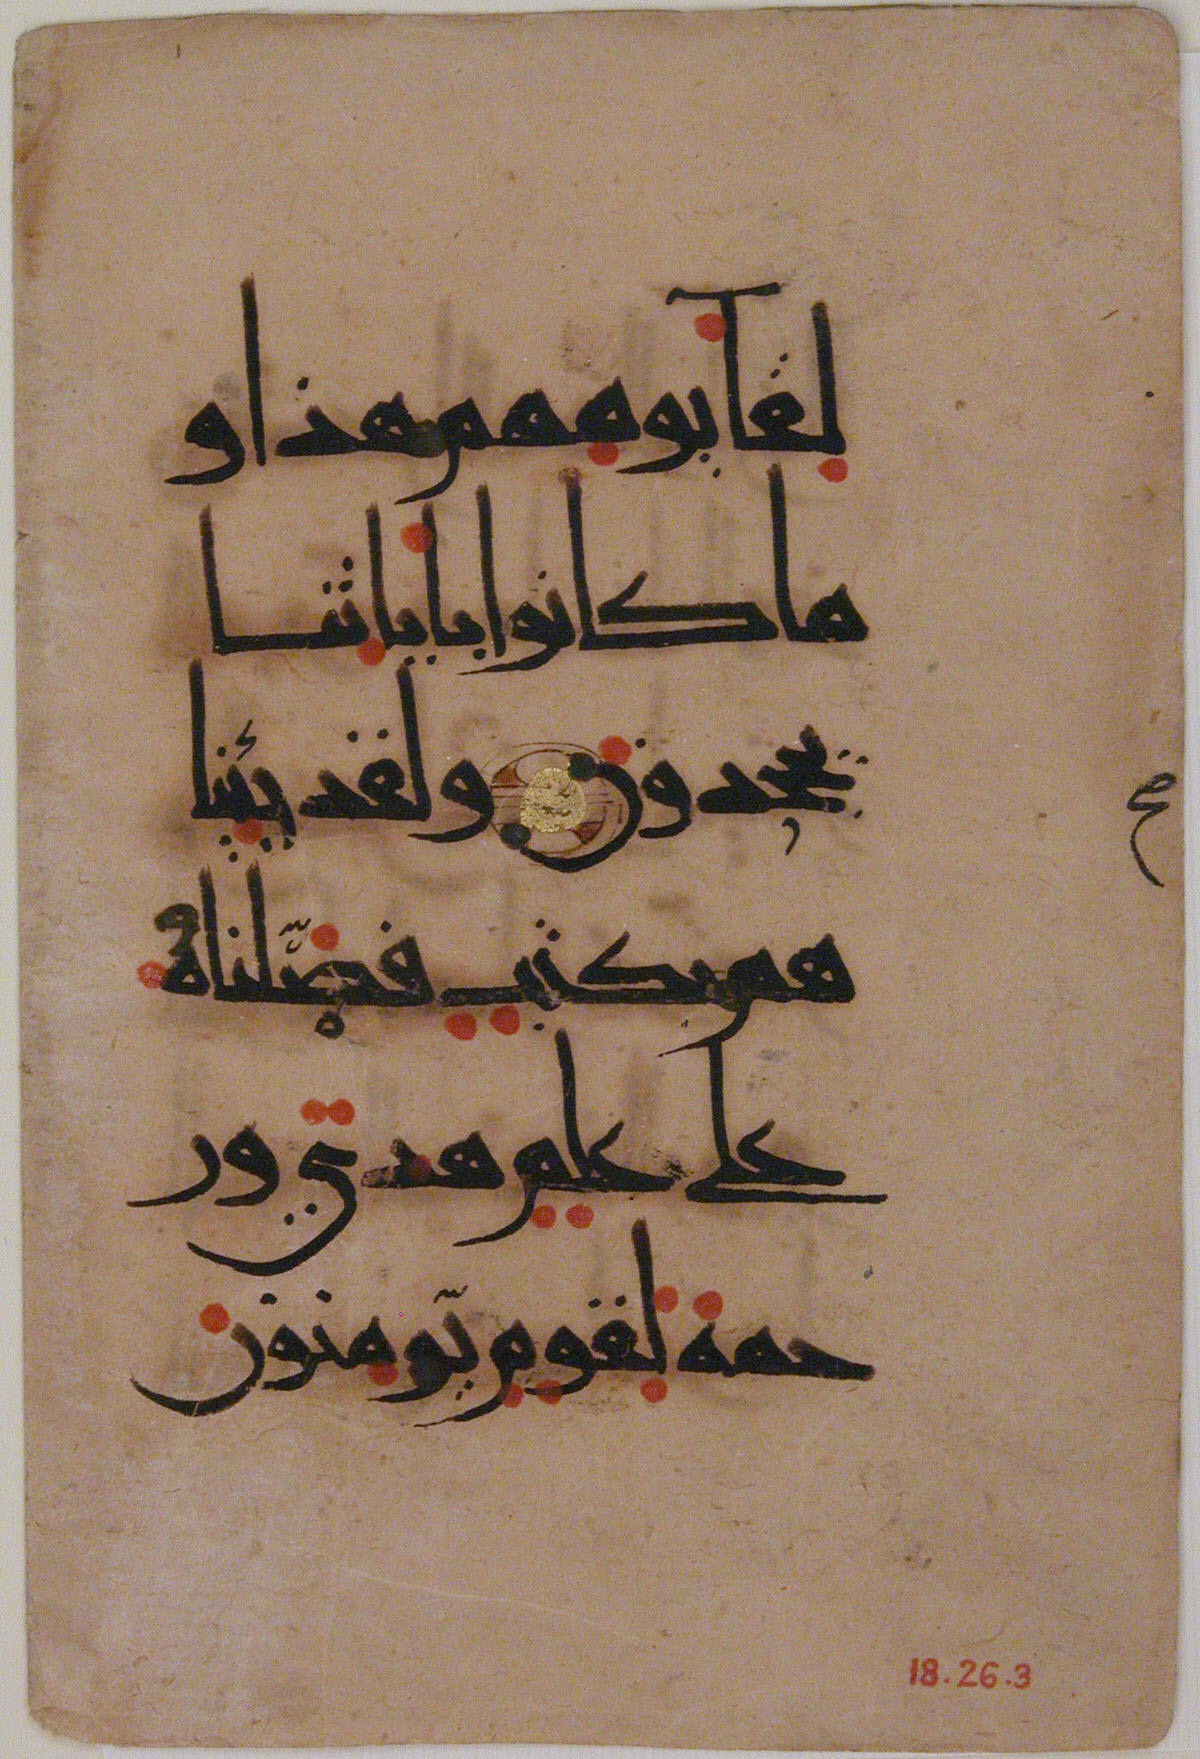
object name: bifolio from a non illustrated manuscript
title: Bi-folium from a Qur'an Manuscript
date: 1001-1200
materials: ink, paper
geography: egypt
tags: qur'an